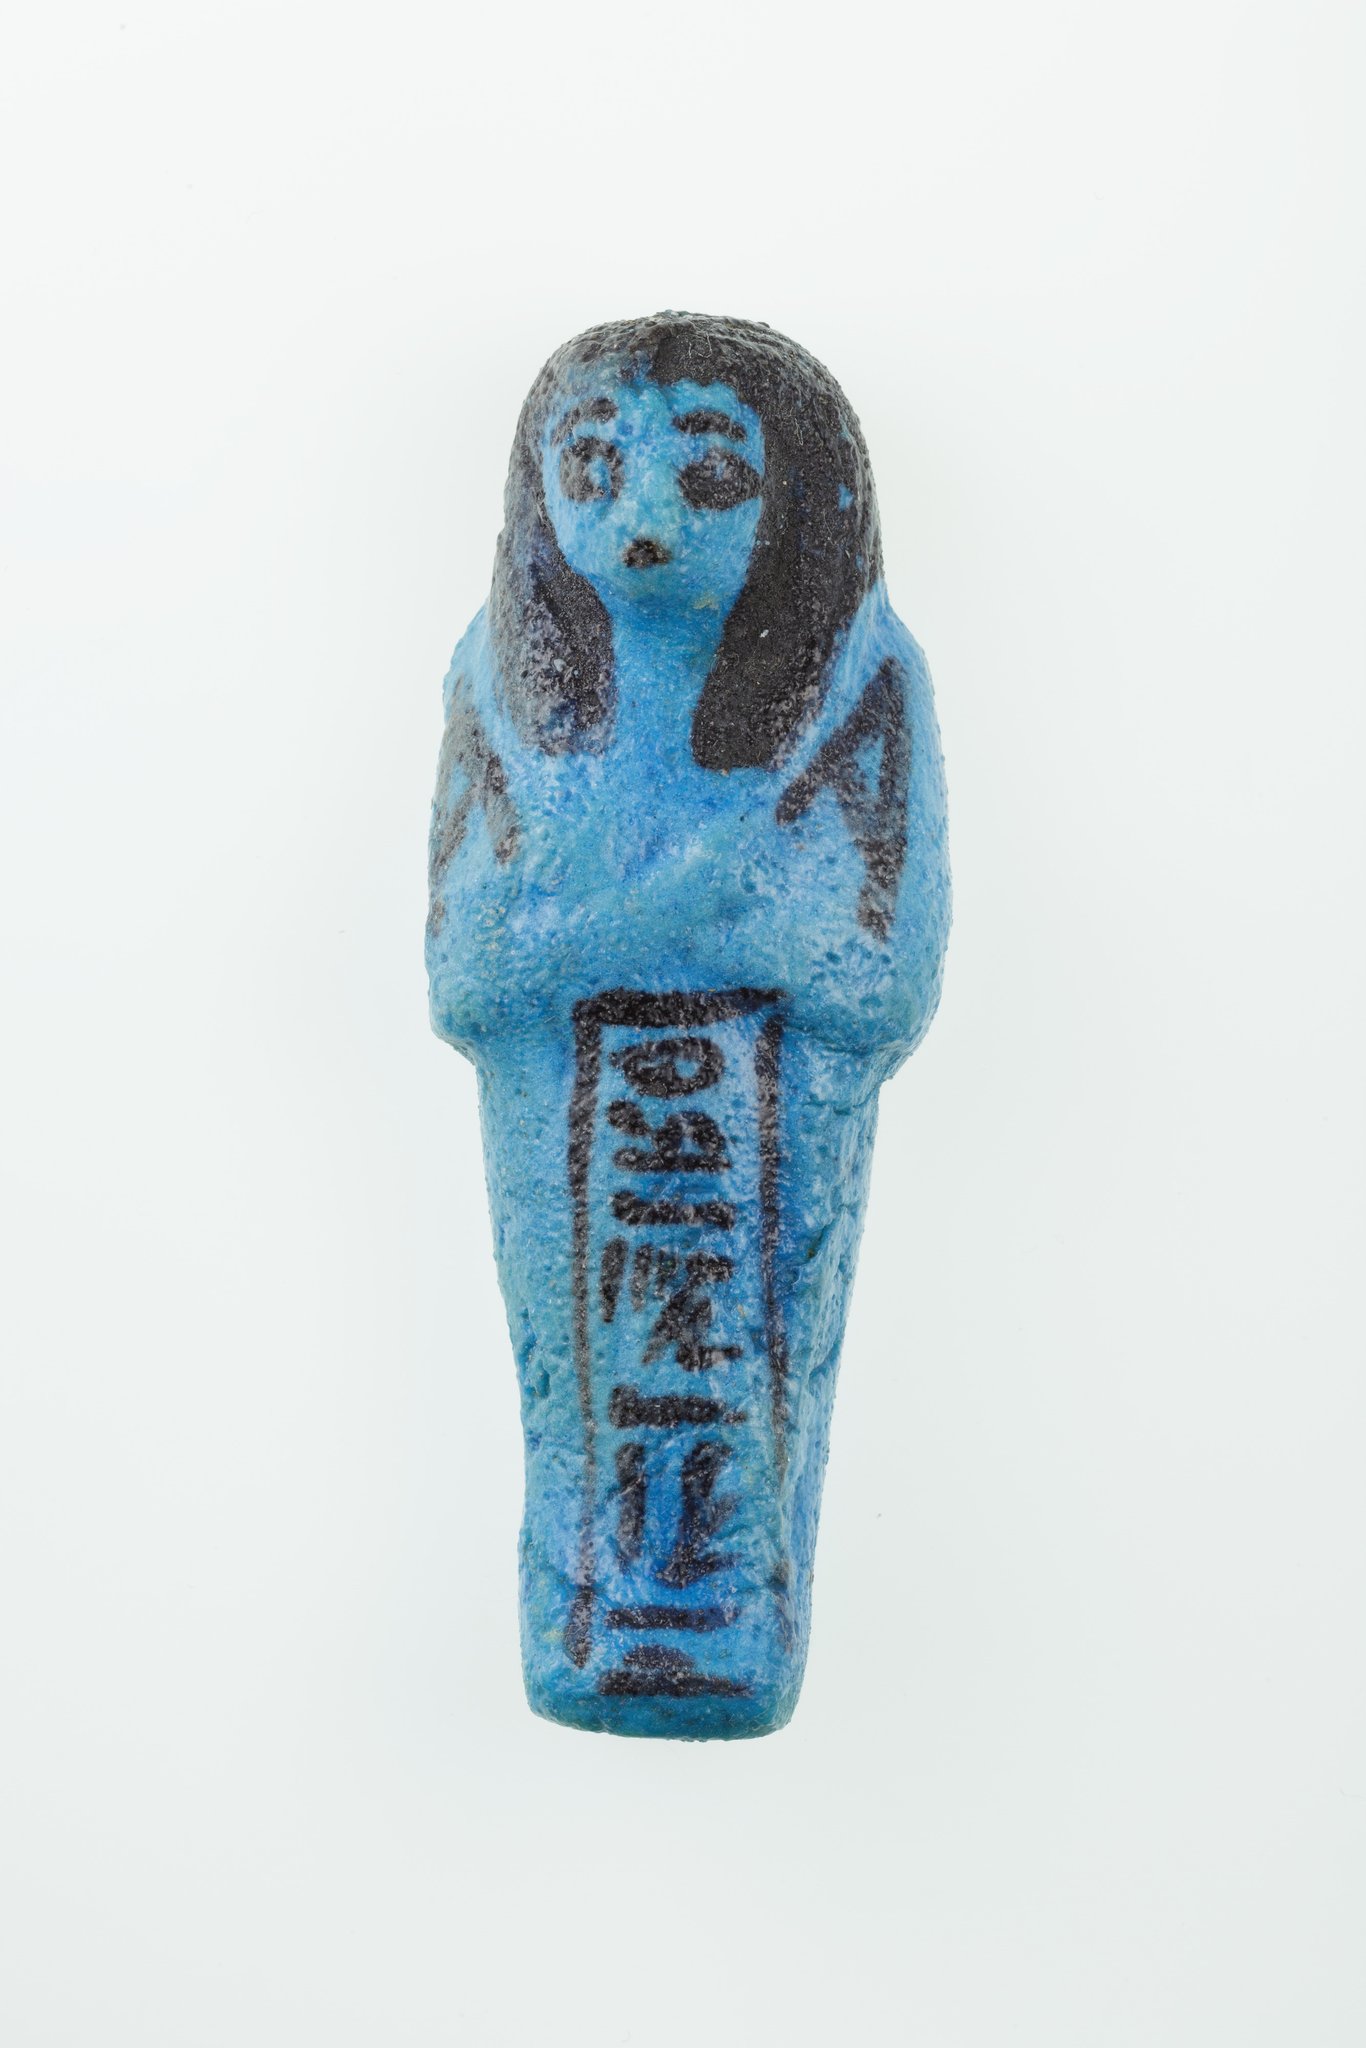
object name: shabti, worker, nauny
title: Worker Shabti of Nauny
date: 1050 BCE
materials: faience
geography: egypt